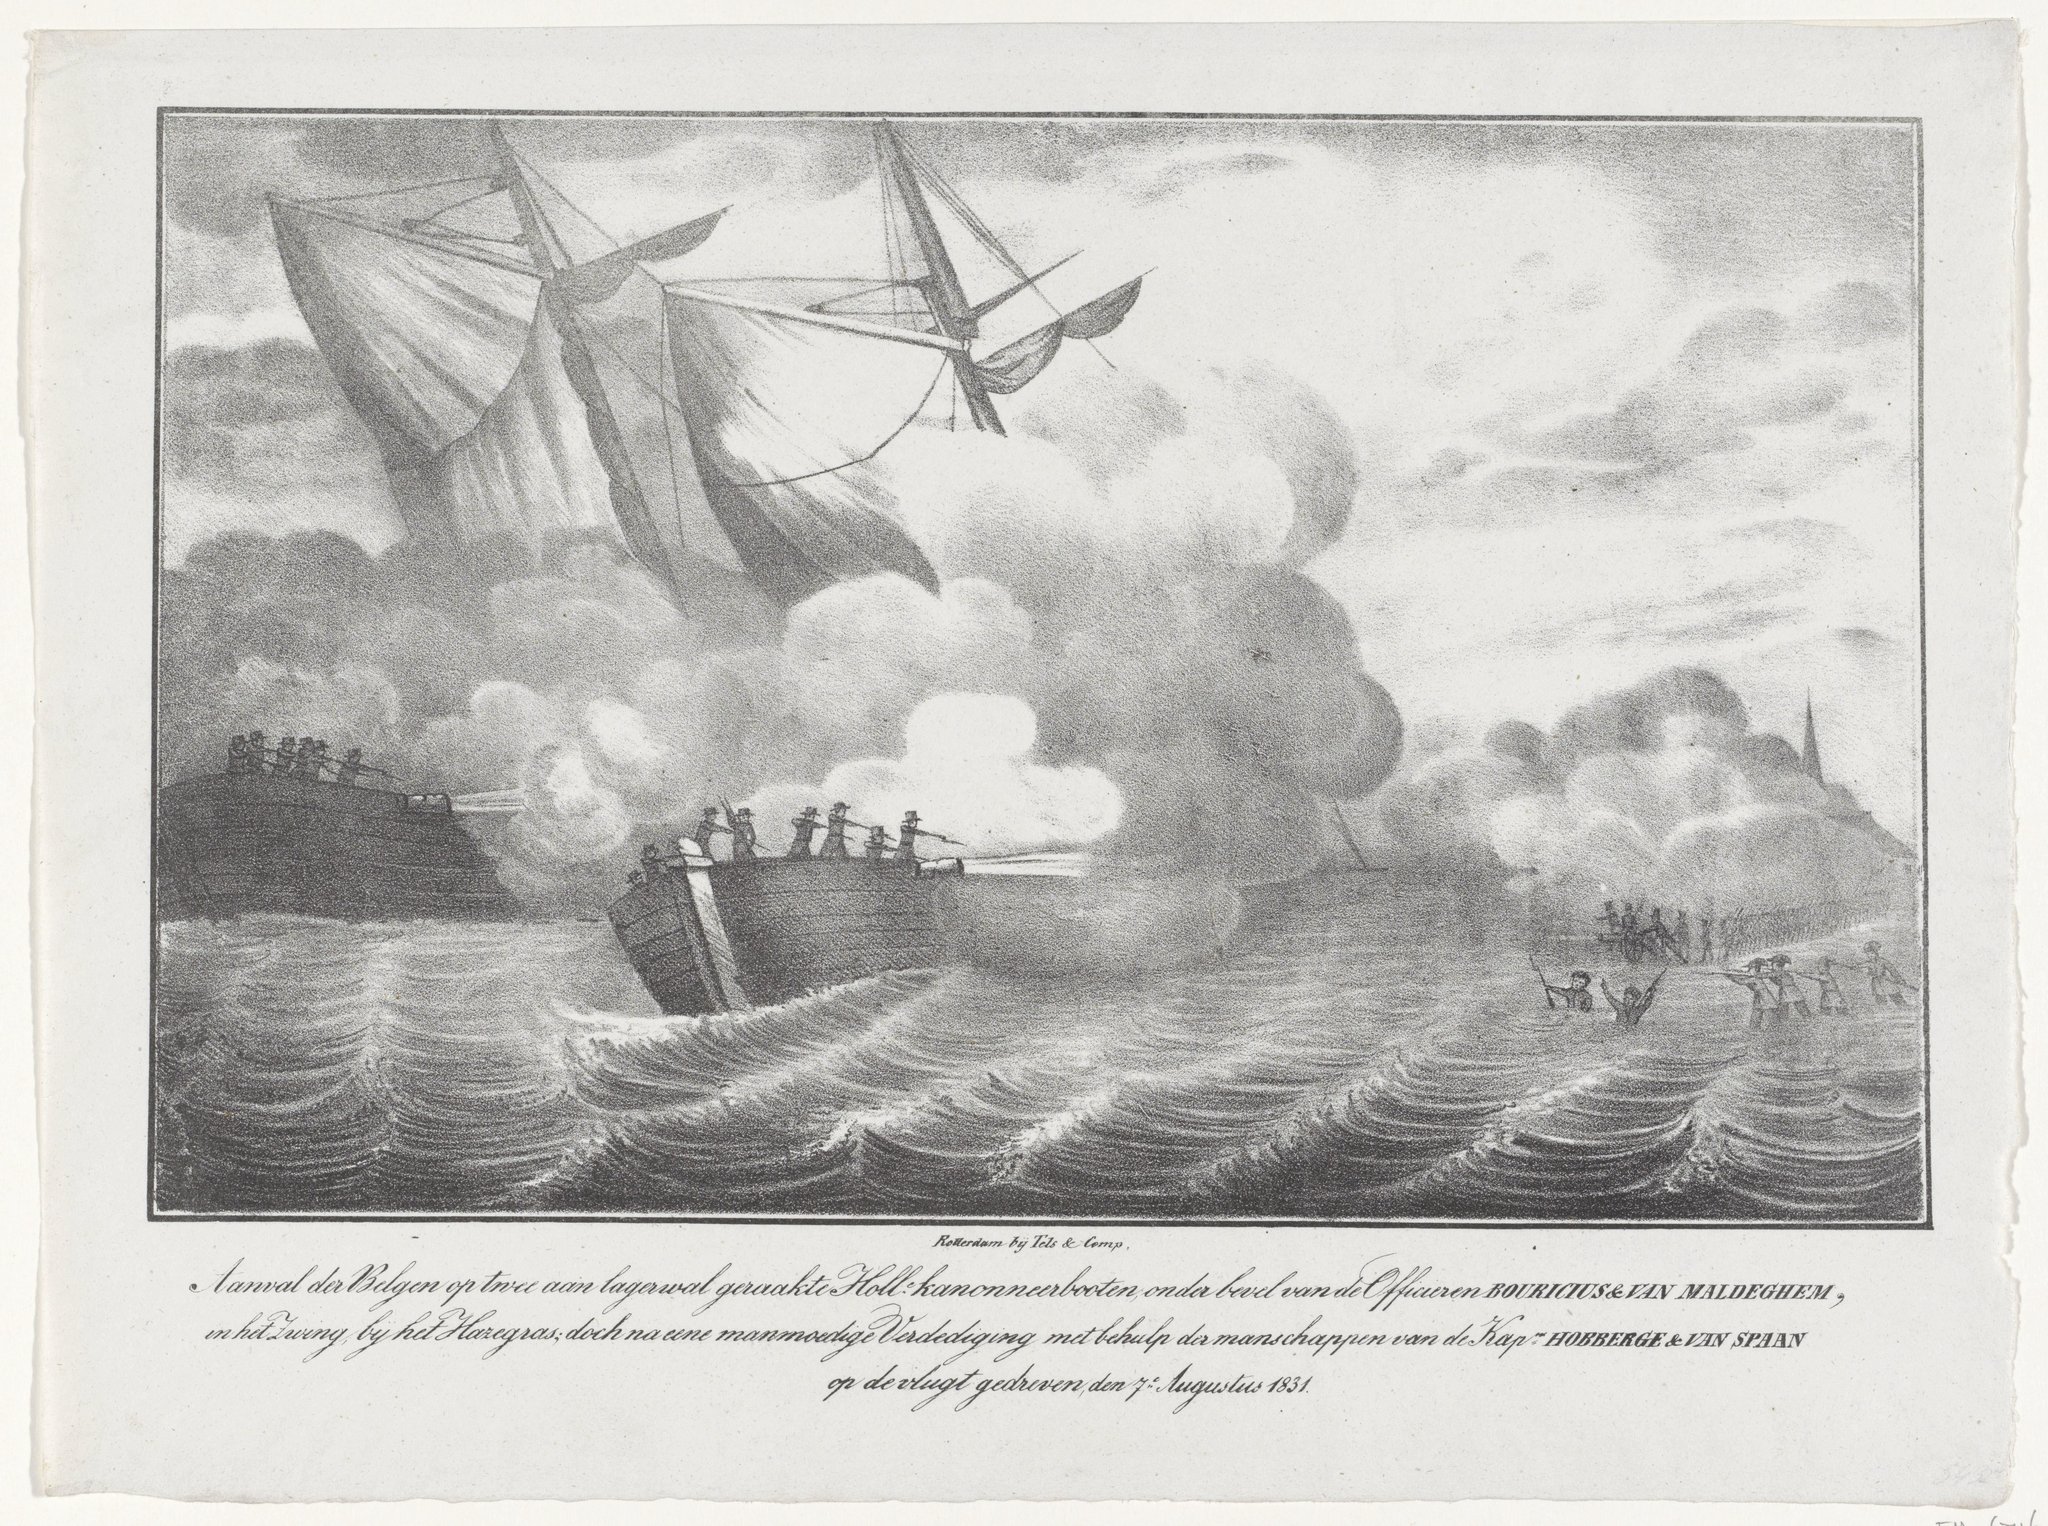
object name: print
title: Afslaan van de aanval op de twee kanonneerboten, 1831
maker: Anonymous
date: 1831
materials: paper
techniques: lithograph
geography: netherlands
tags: small groups in single combat in place of battle (+ naval force)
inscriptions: collector's mark: Lugt 2228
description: Het afslaan van de aanval door Belgische militairen op de twee aan lager wal geraakte Nederlandse kanonneerboten, 7 augustus 1831. Onderdeel van een serie van drie platen.